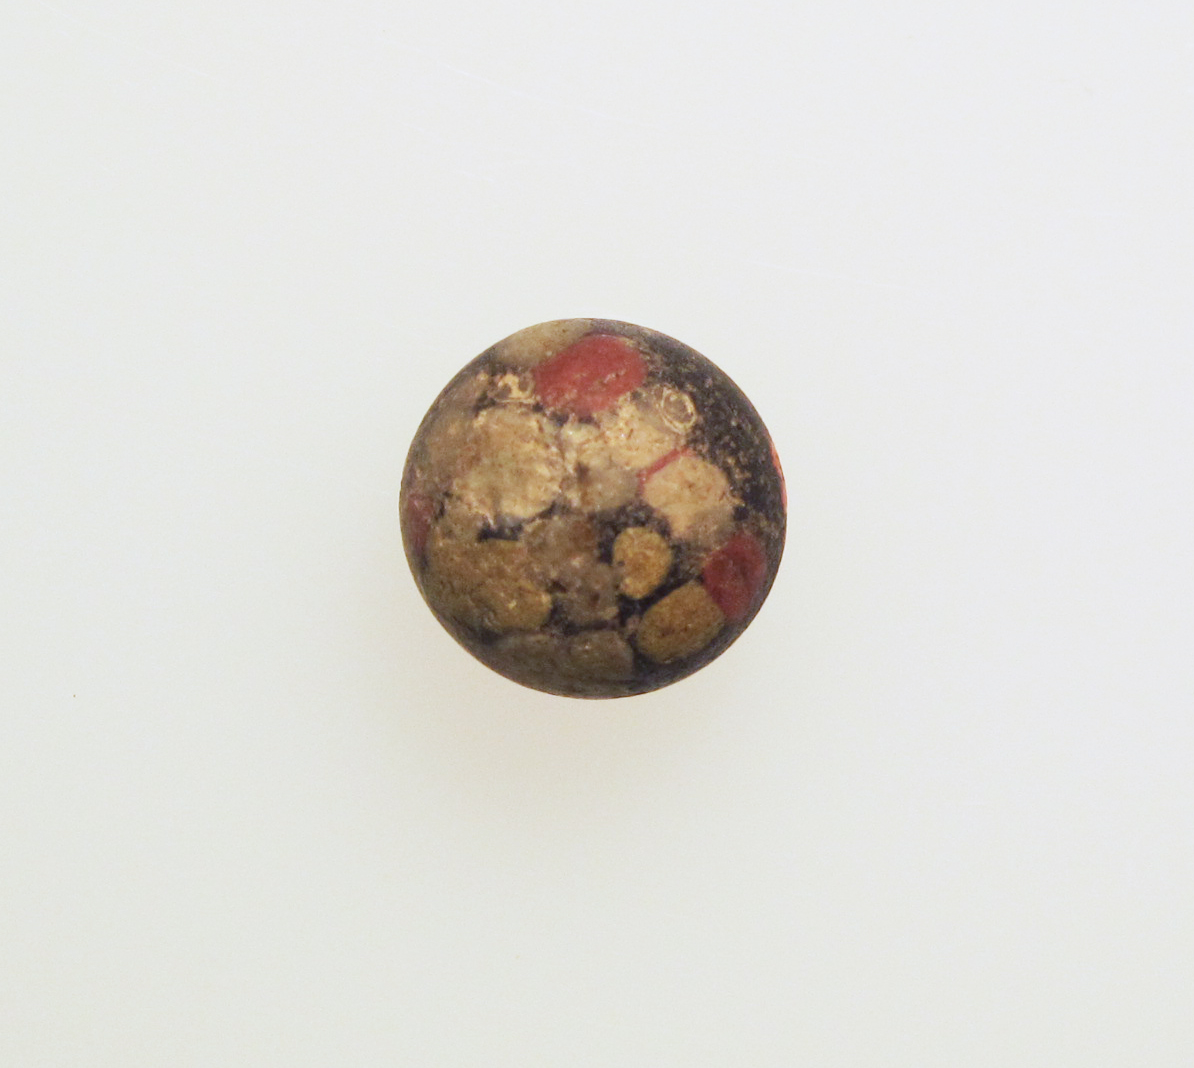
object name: pinhead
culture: roman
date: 670 BCE-330 CE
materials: glass